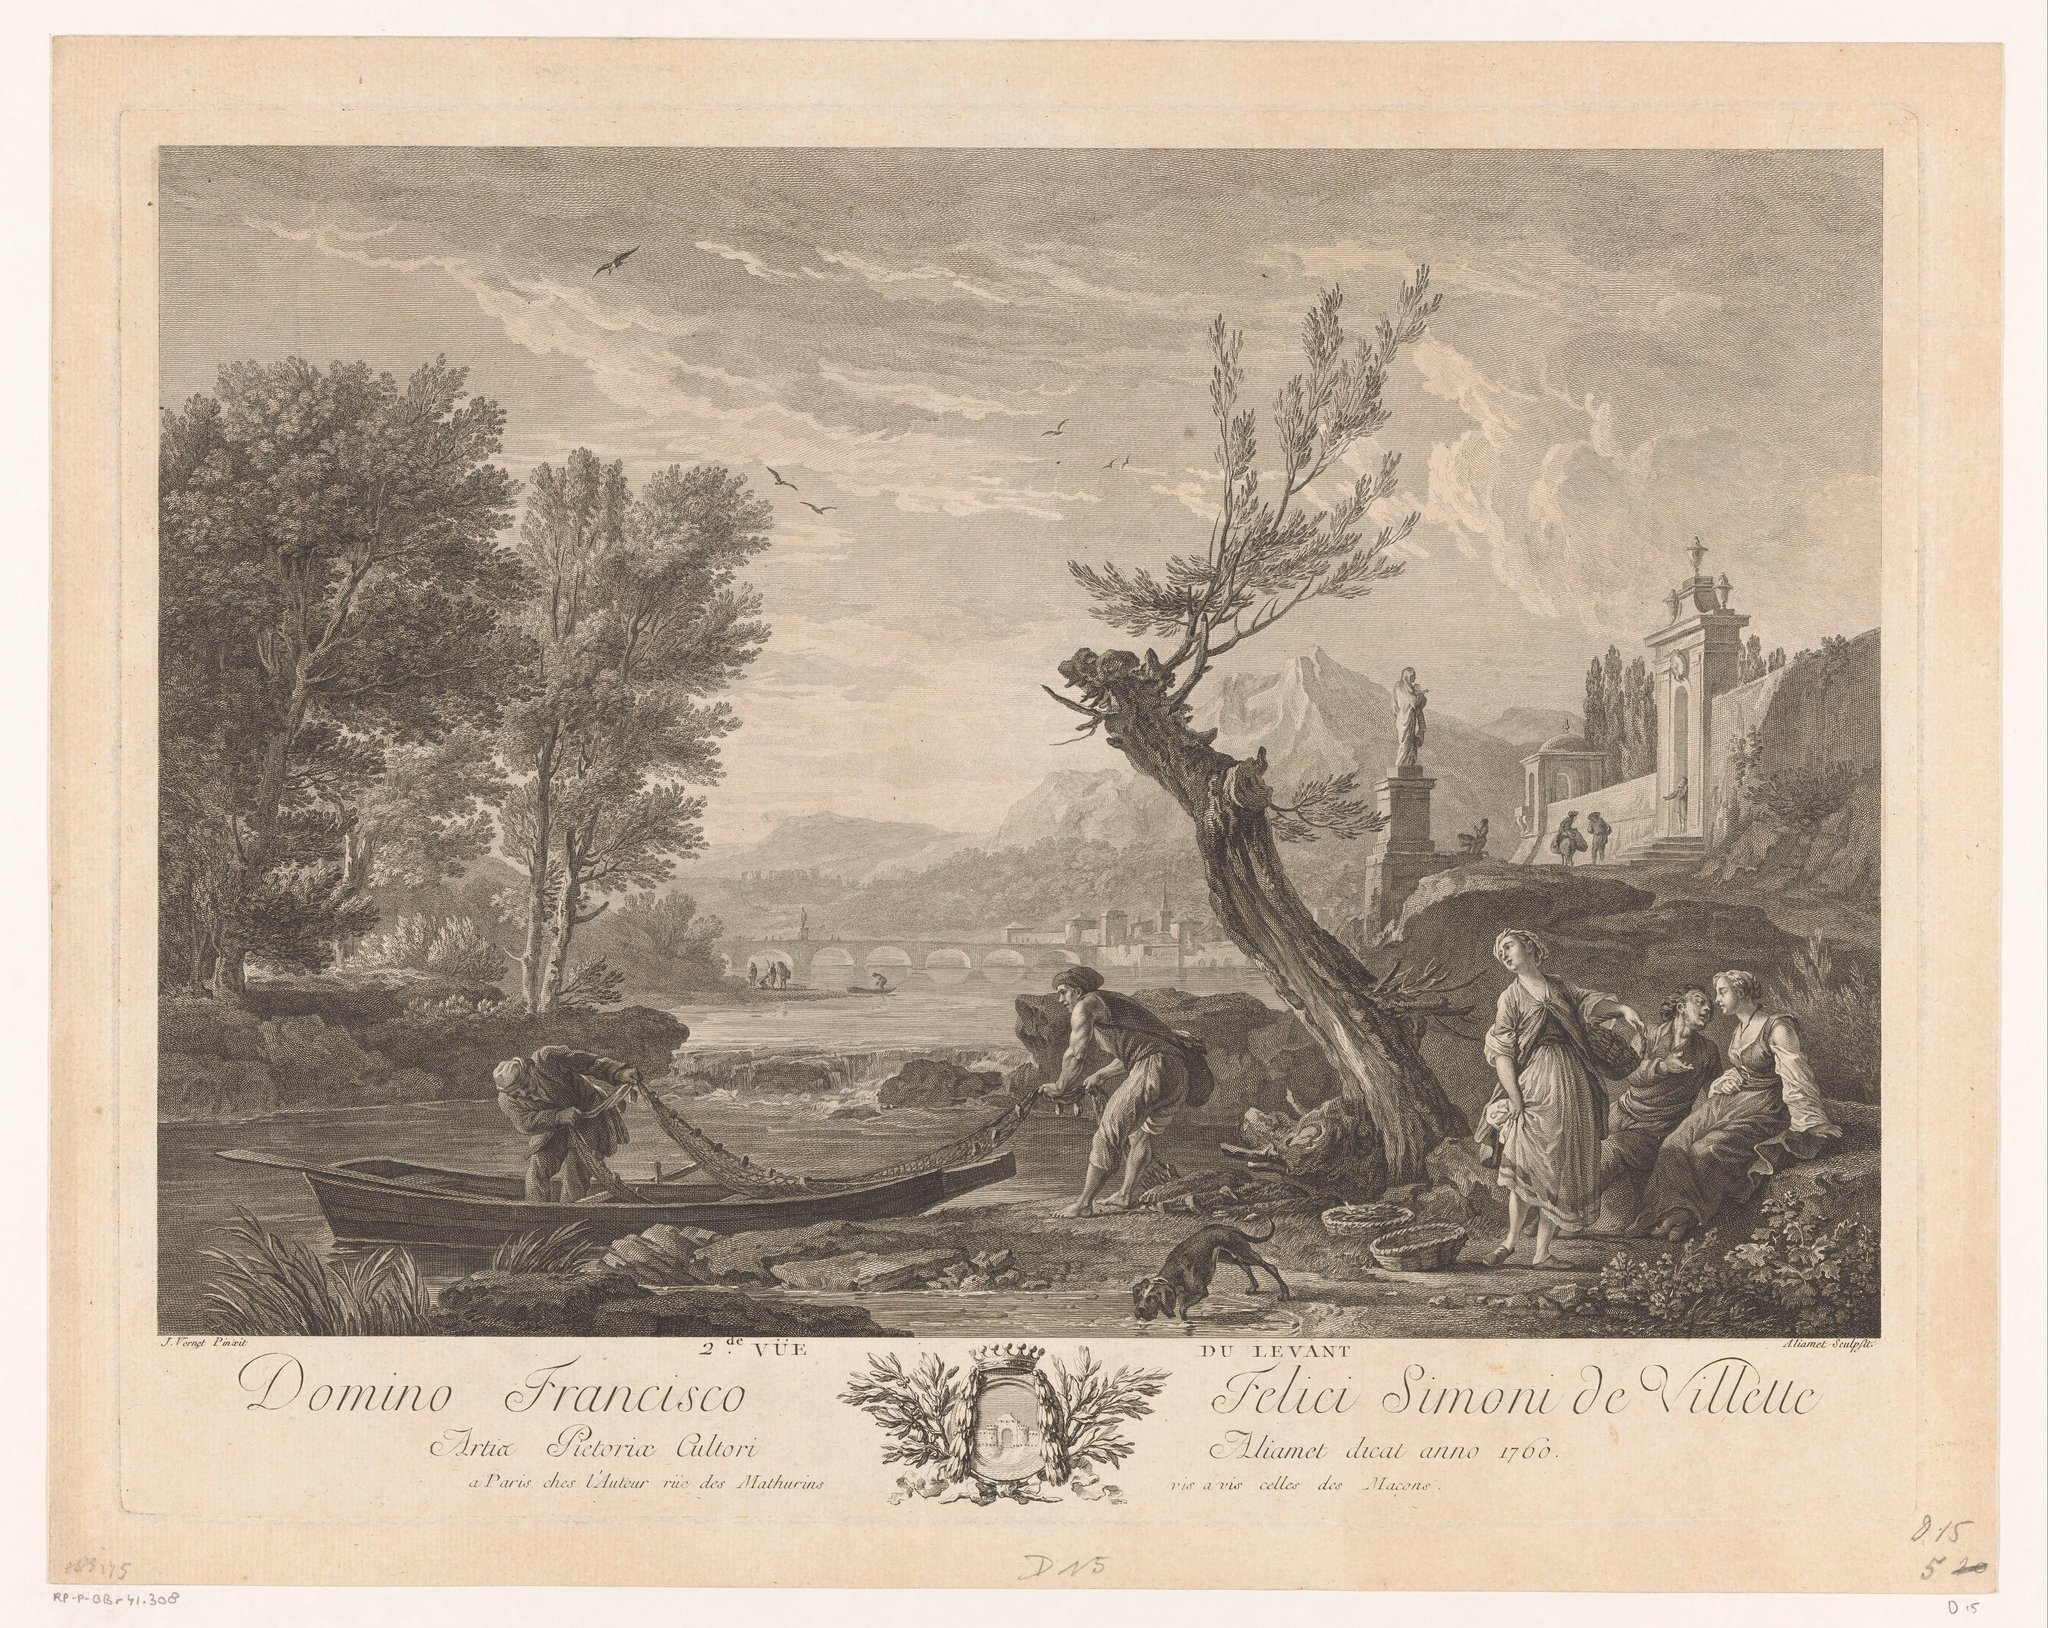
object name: print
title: Rivierlandschap in de Levant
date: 1760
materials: paper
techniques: engraving, etching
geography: paris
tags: river, city-walls, bridge, fisherman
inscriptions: collector's mark: Lugt 2228